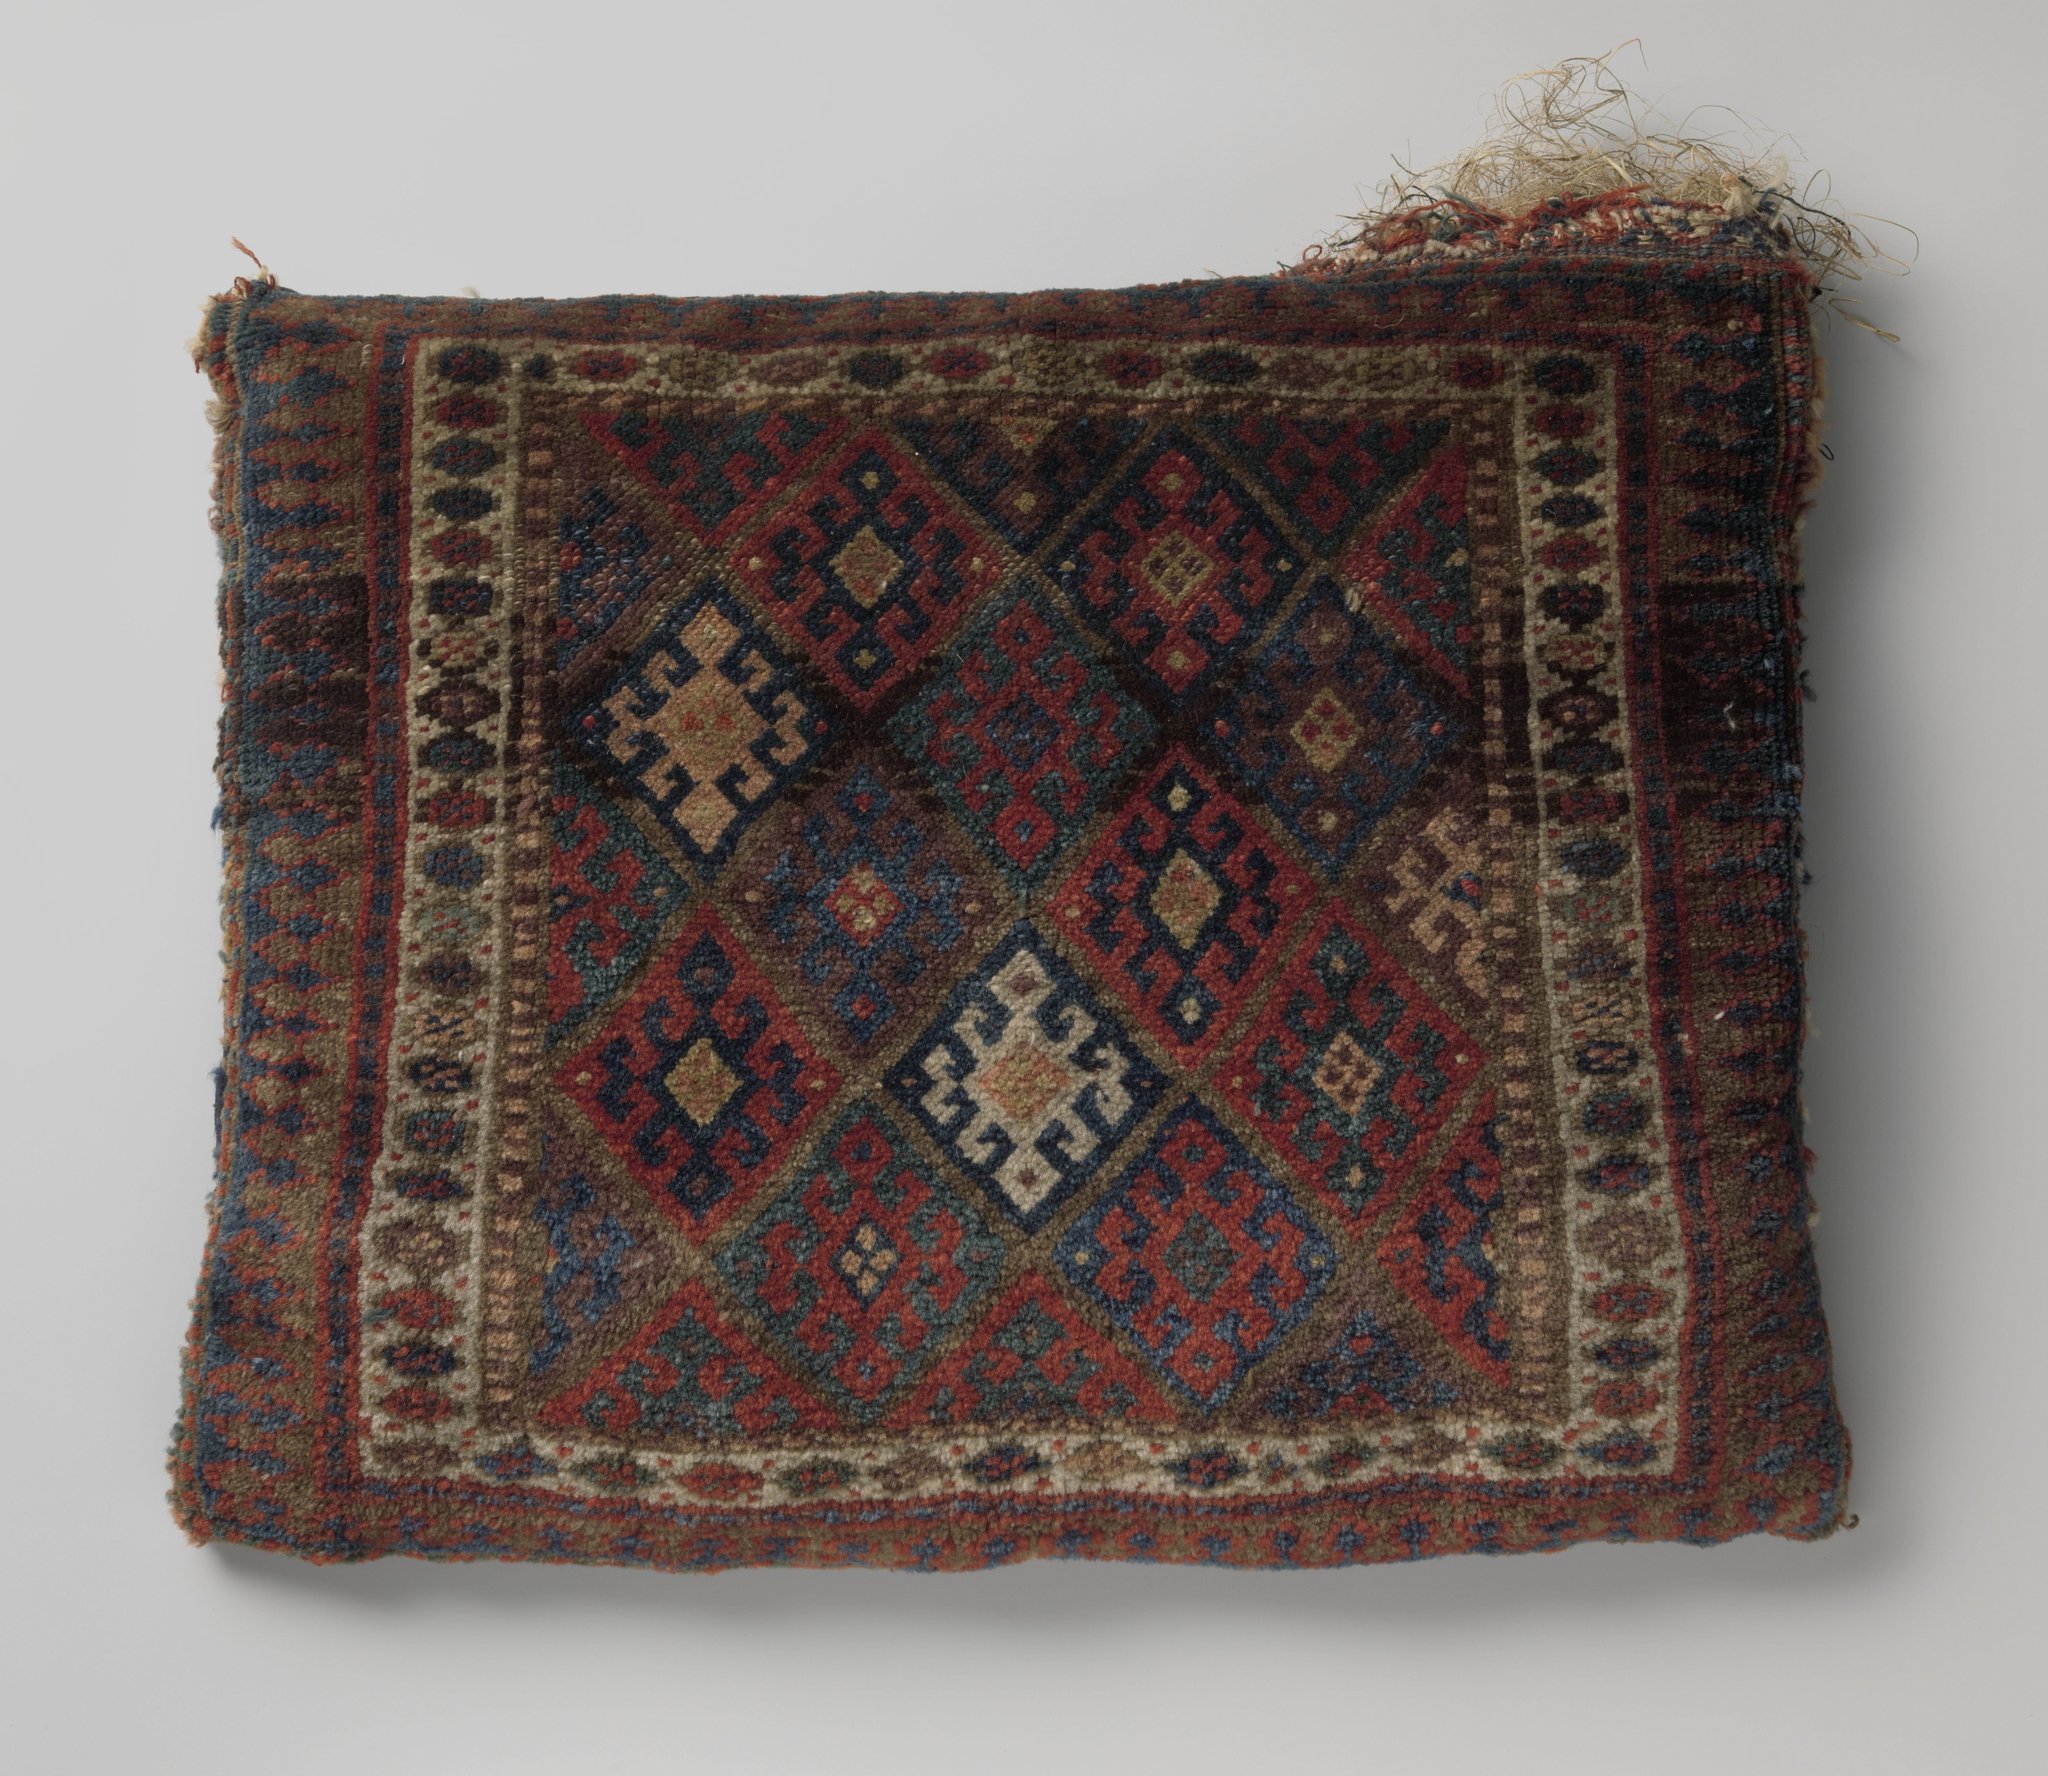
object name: zadeltas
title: Voorblad zadeltas, versierd met rasterwerk waarbinnen kruisbloemen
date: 1800-1900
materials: wool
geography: kurdistan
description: Voorblad van een zadeltas, Jaffi Kurdistan-Mosul. Het middenveld is door een rasterwerk verdeeld in ruiten waarbinnen kruisbloemen. Dubbele rand. Bovenaan een van sluitspleten voorziene baard.